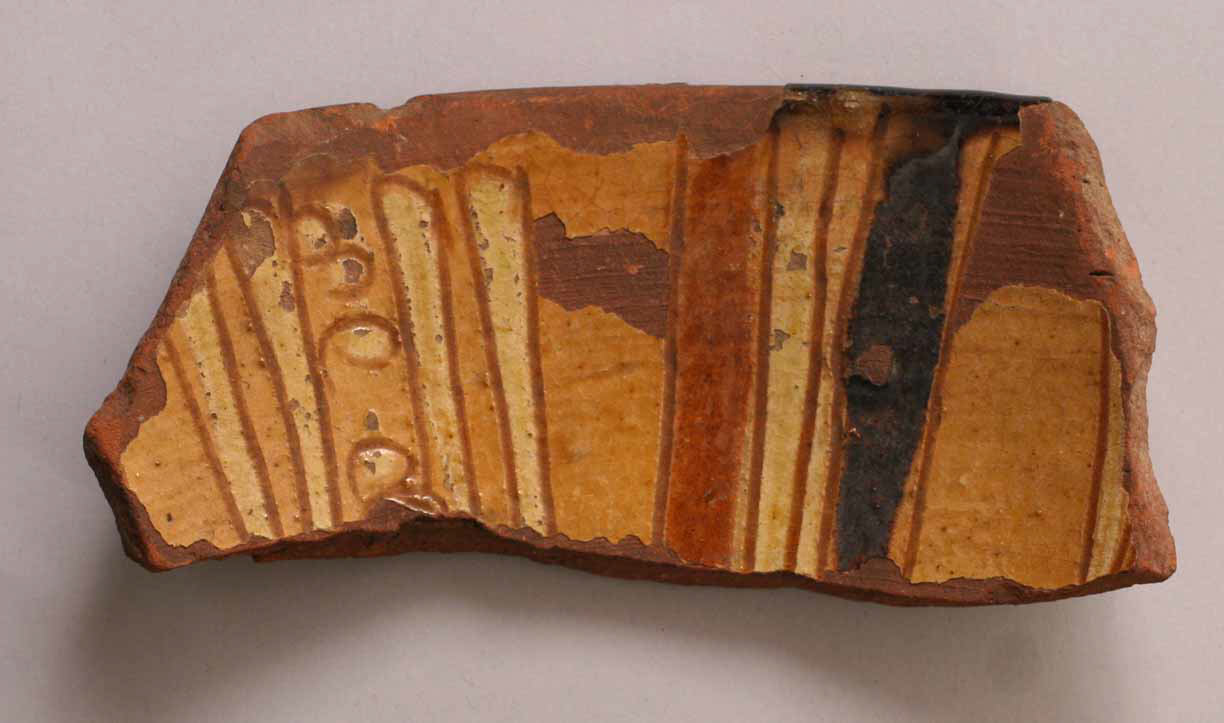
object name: fragment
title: Ceramic Fragment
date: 1301-1500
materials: earthenware, glaze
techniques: coloring, incising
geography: egypt